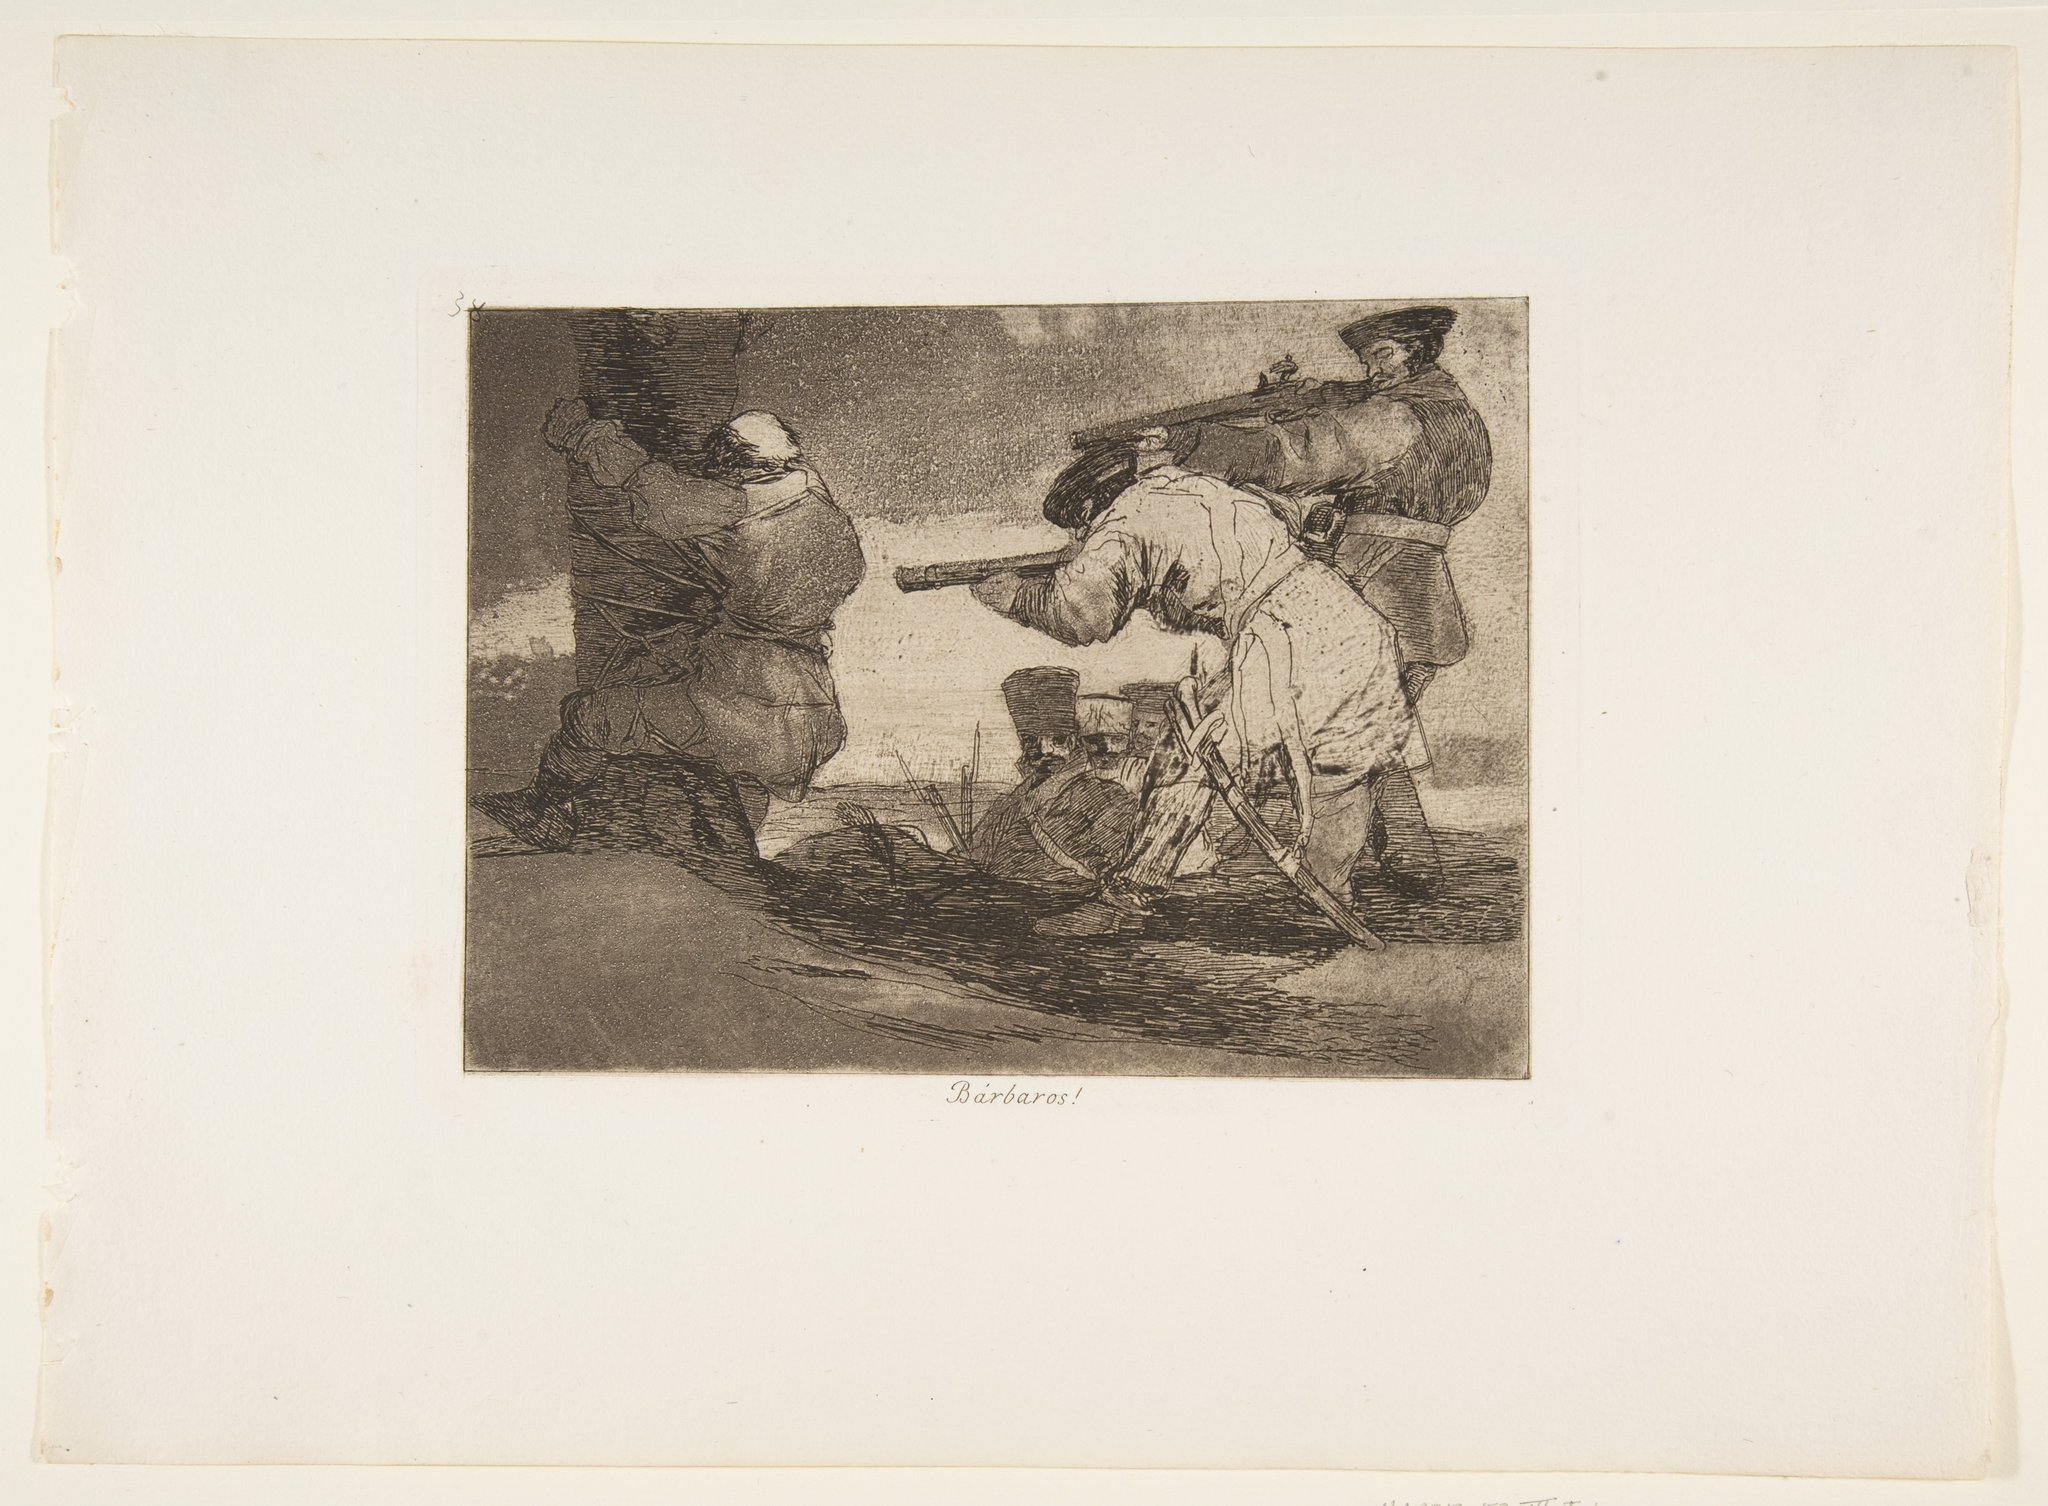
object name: print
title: Plate 38 from "The Disasters of War" (Los Desastres de La Guerra): Barbarians! (Bárbaros!)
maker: goya (francisco de goya y lucientes)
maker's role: artist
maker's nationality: spanish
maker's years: 1746-1828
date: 1810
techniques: aquatint, engraving, burnishing, etching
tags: firearms,men